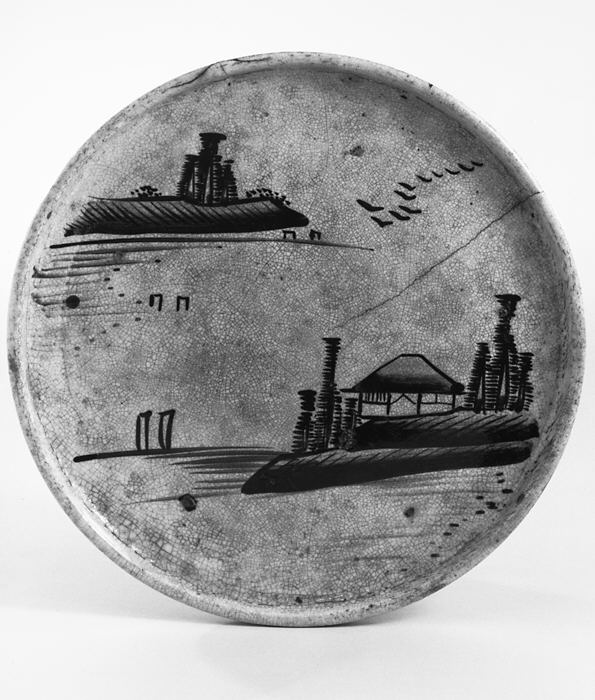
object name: plate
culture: japanese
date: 1801-1900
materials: iron, pigment, wood, pottery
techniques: painting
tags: landscapes